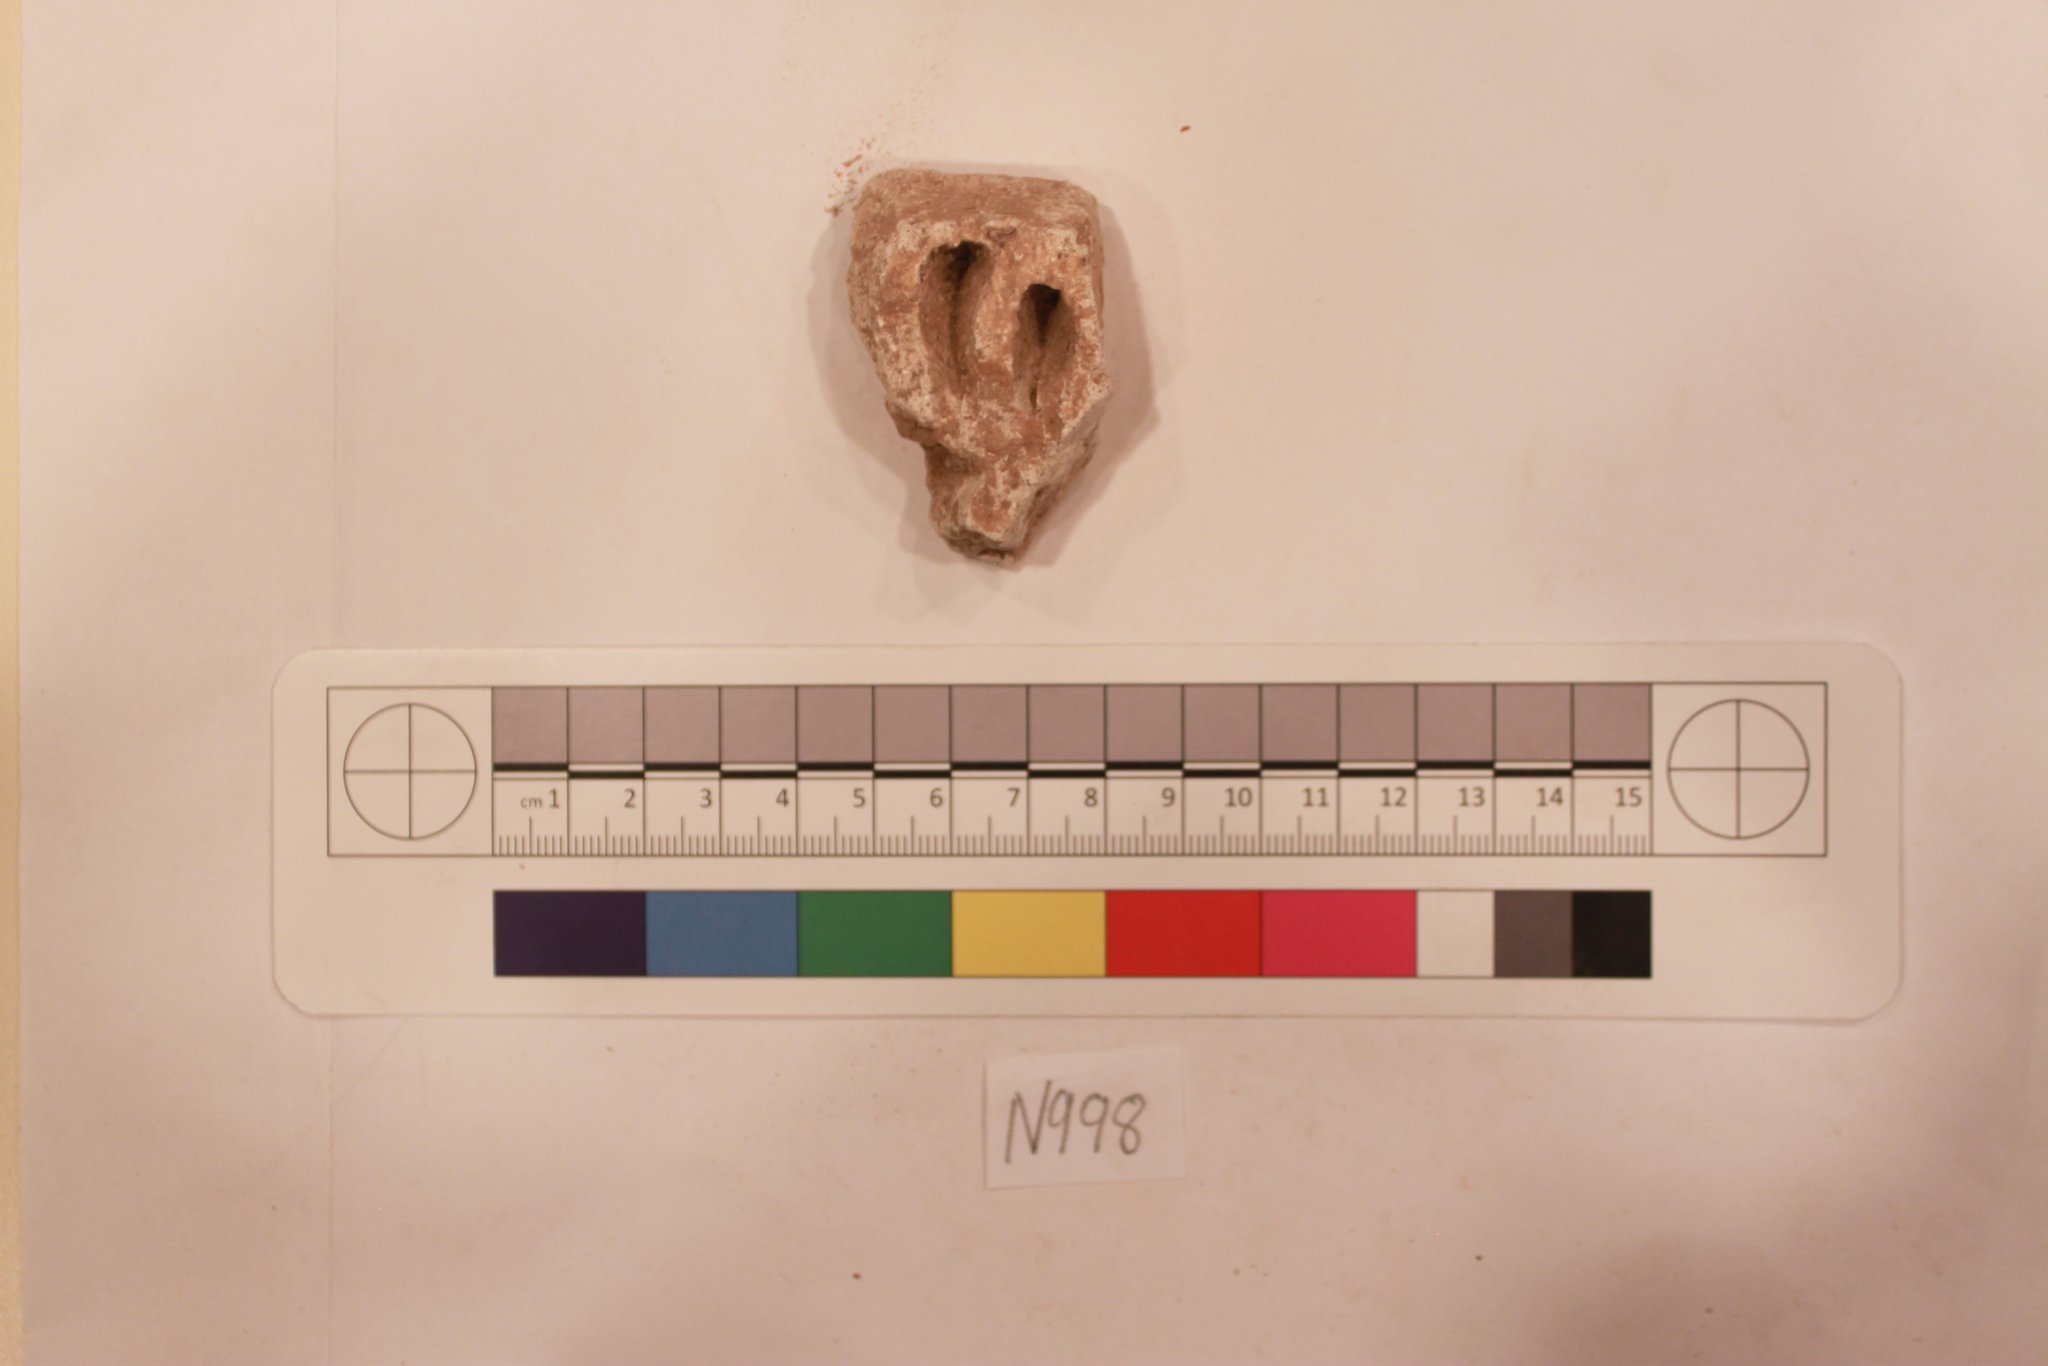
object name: fragment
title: Stucco Fragment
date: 701-1200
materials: plaster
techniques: carving, painting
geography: iran